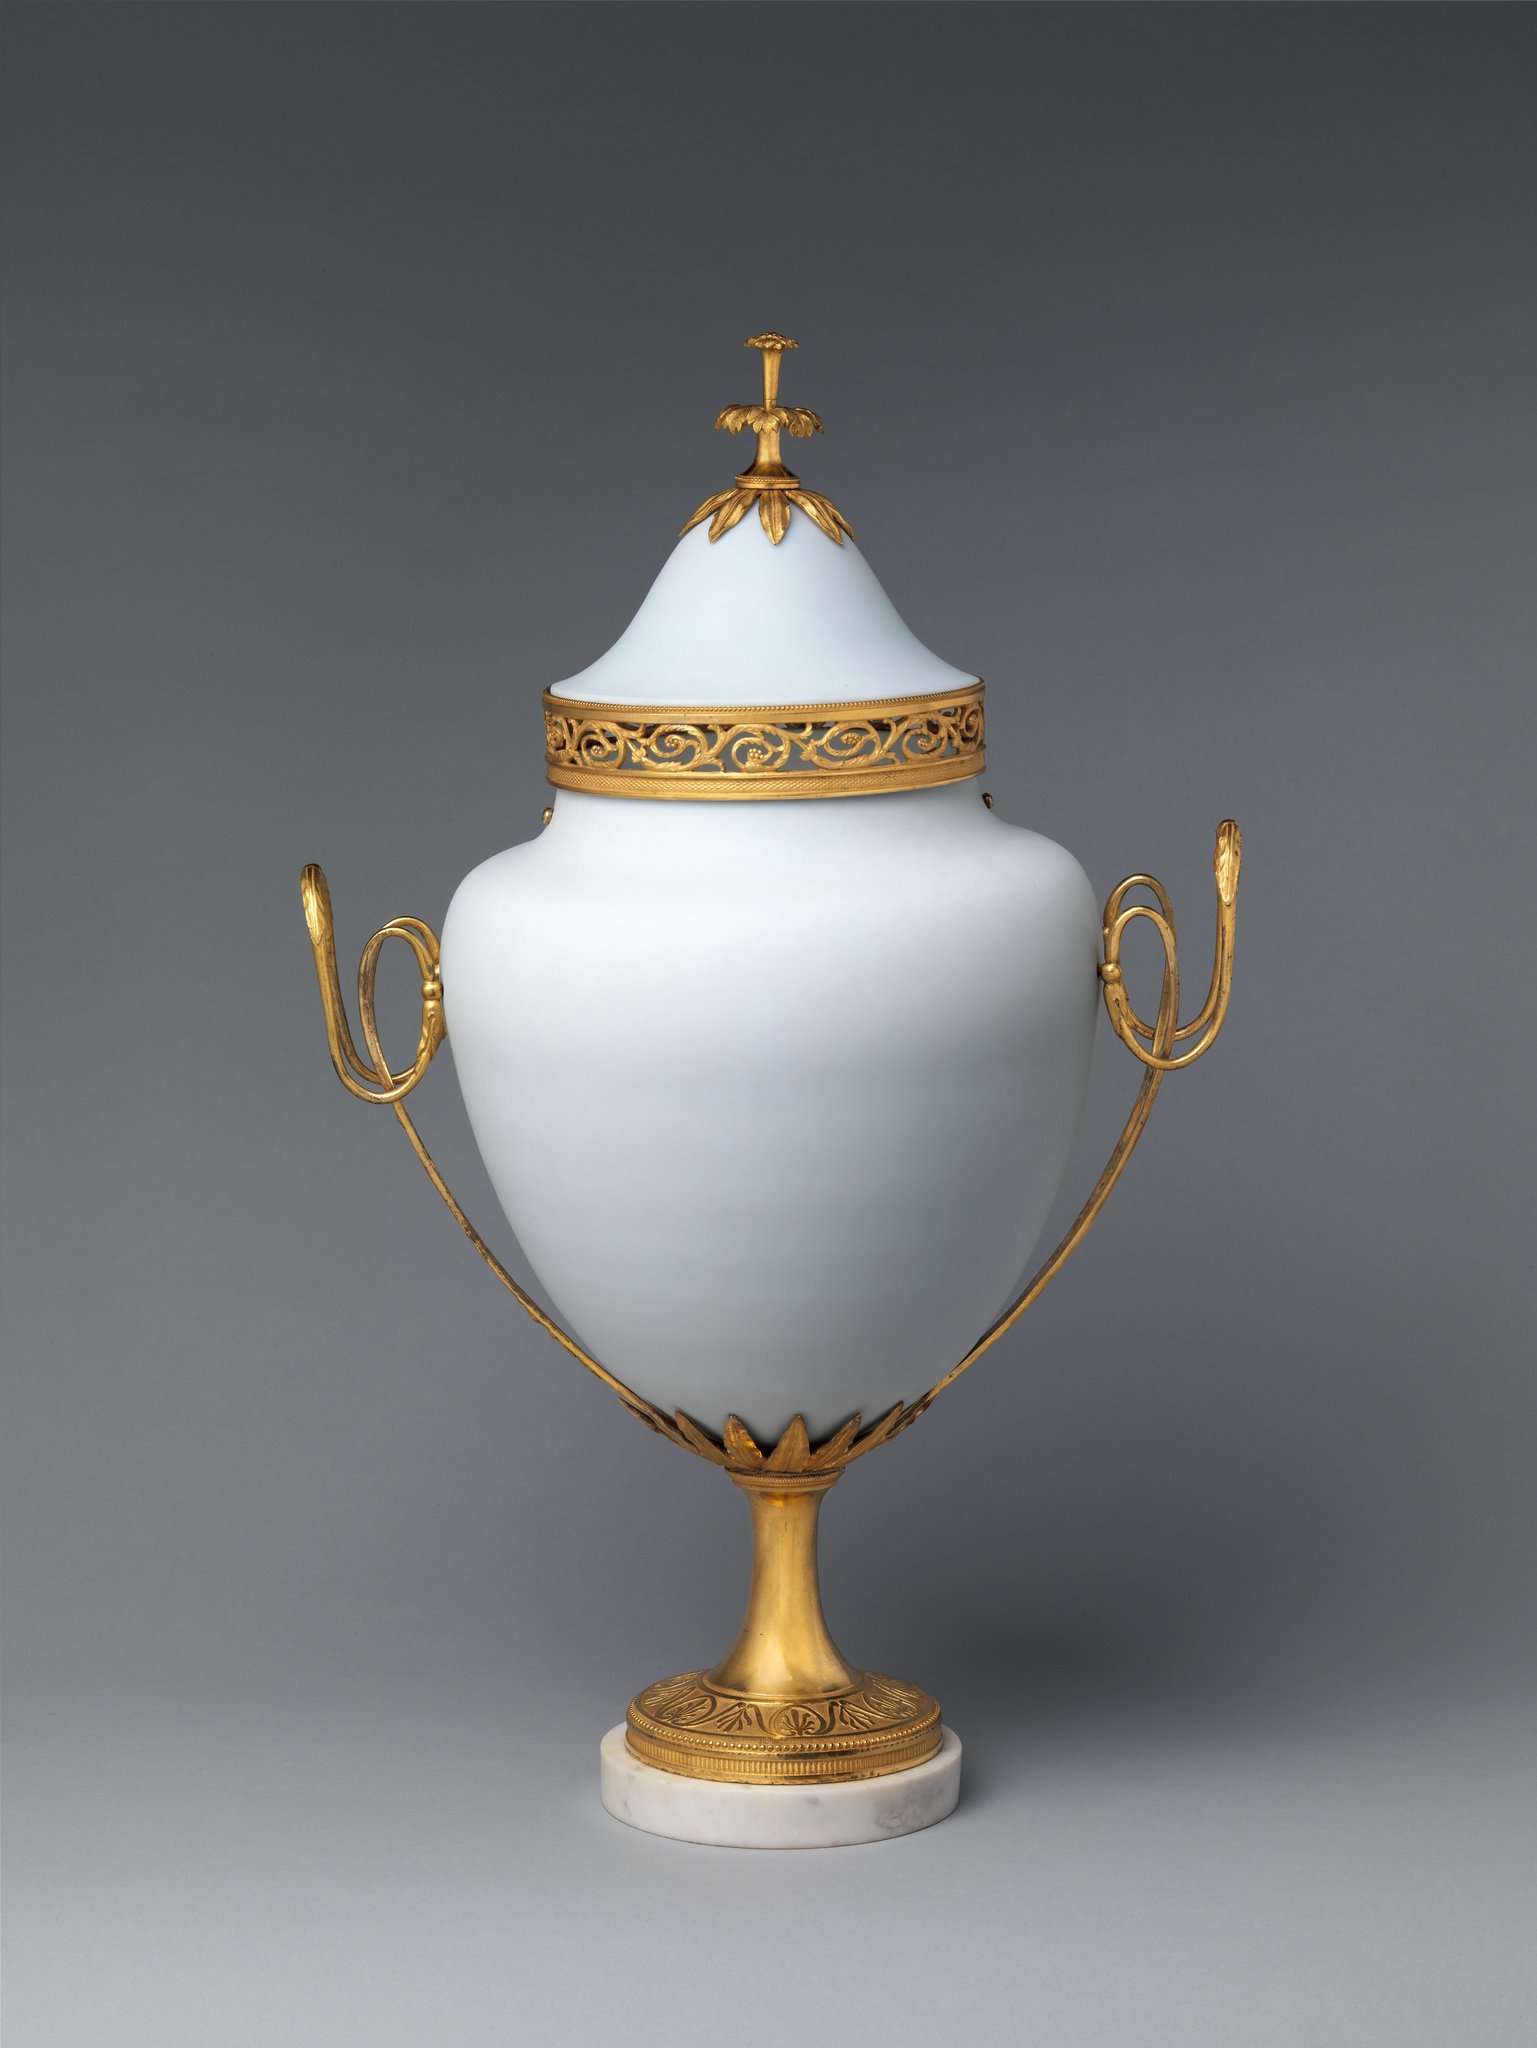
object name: potpourri vase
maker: karl friedrich schinkel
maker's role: artist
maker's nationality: german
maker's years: 1781-1841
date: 1810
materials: glass, marble, metal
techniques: gilding